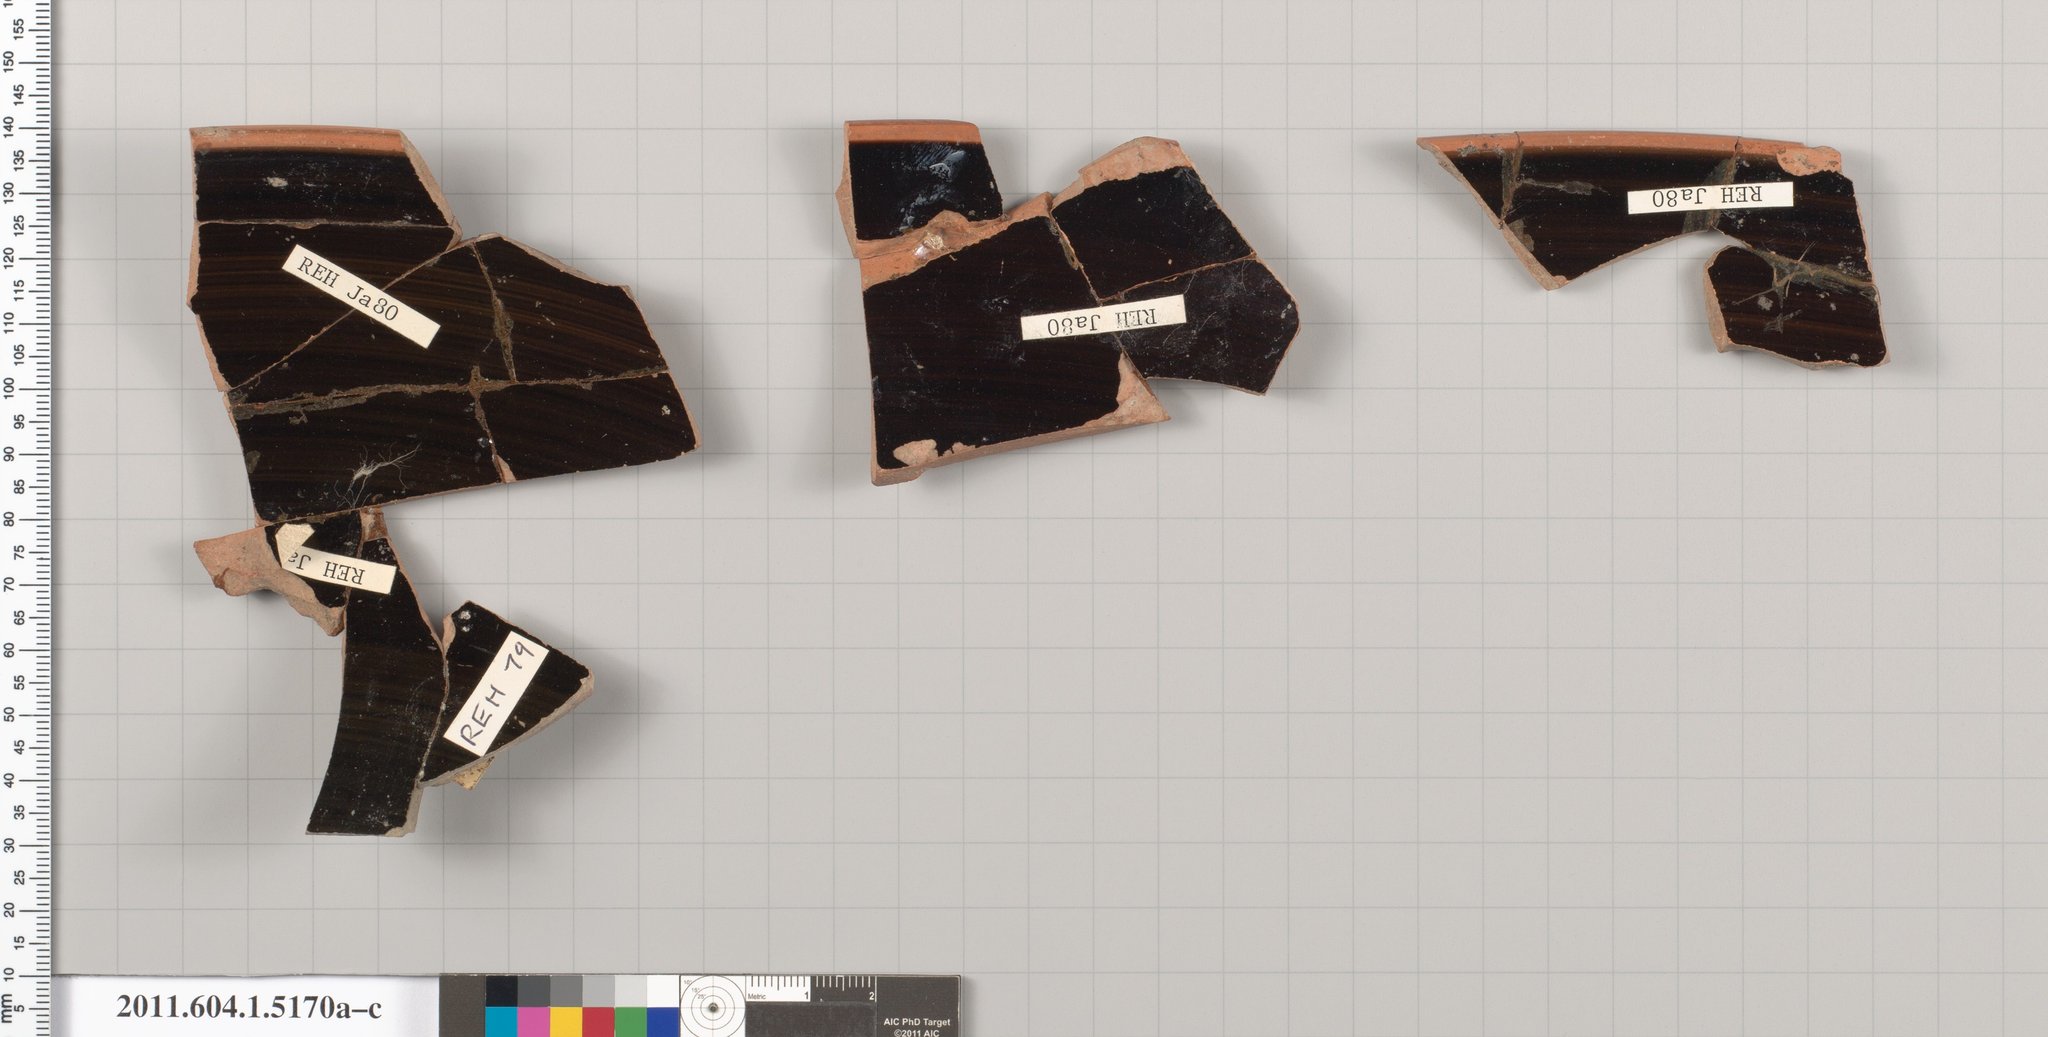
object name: kylix fragment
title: Terracotta rim fragments of a kylix (drinking cup)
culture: greek, attic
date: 520-500 BCE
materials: terracotta